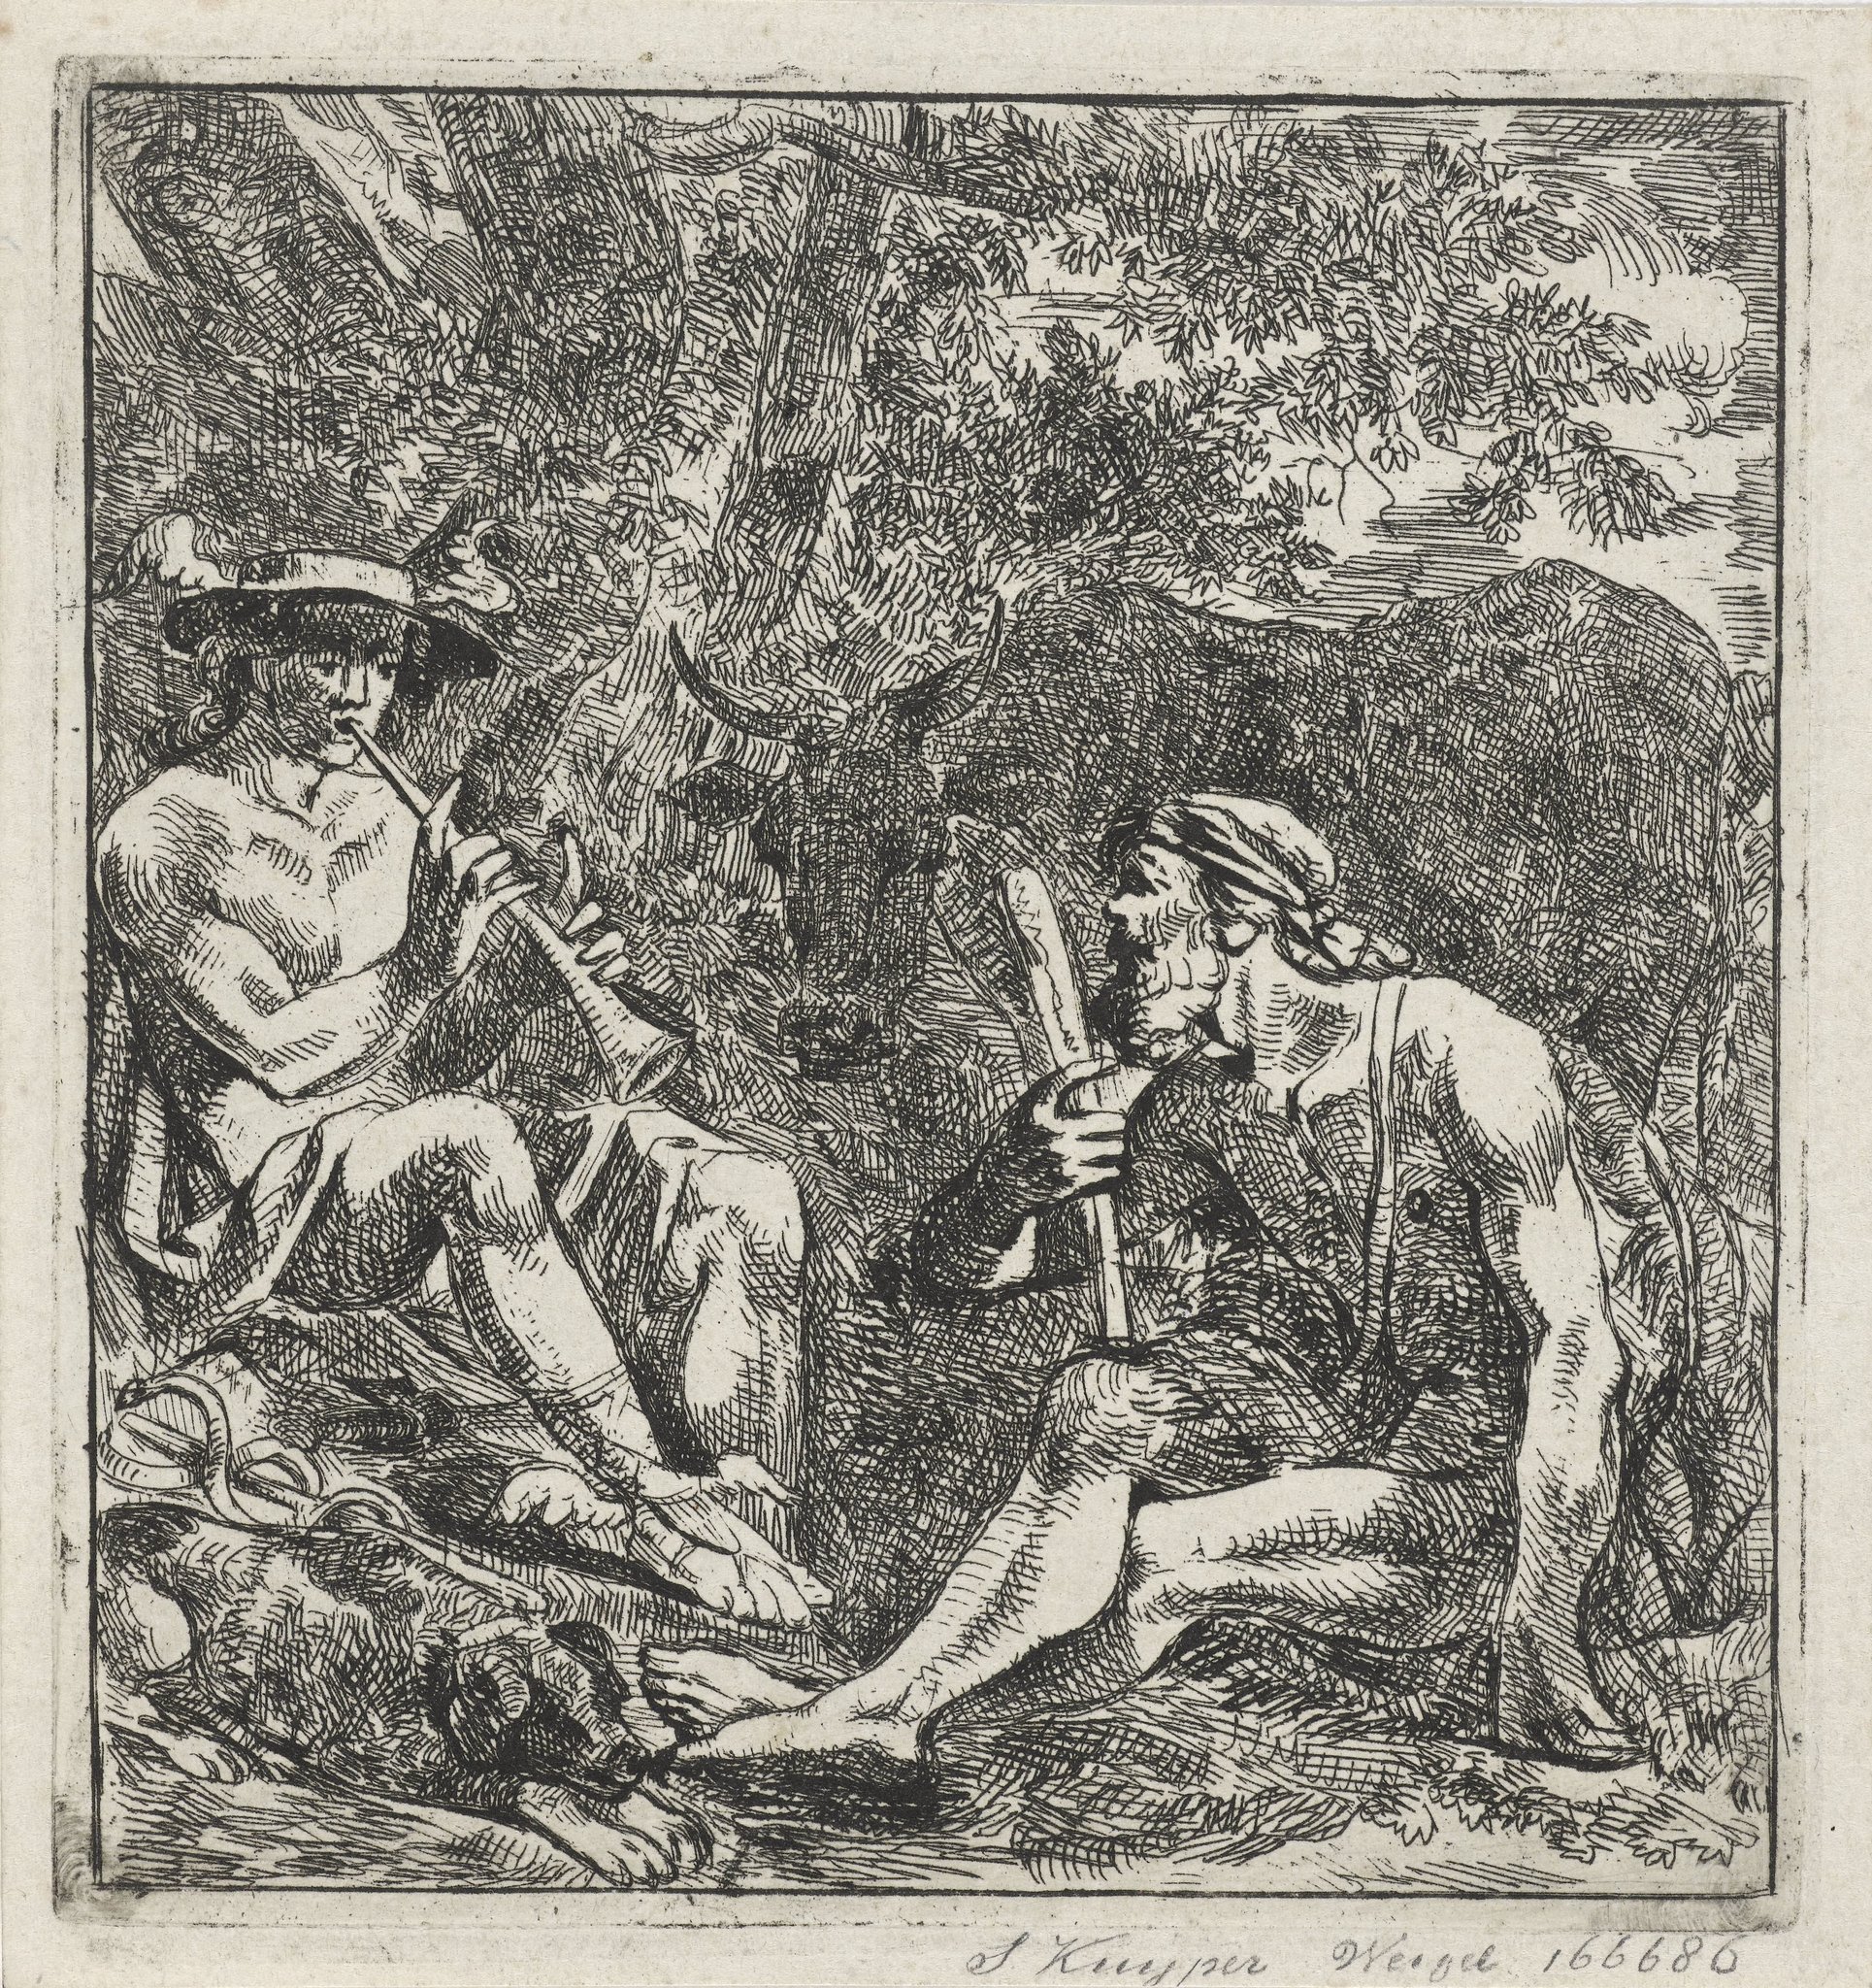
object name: print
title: Mercurius, Argus en Io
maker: jacques kuyper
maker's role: draughtsman, print maker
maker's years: 1761-1808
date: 1771-1808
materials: paper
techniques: etching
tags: mercury lulls argus into sleep by making music, dog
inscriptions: inscription: ‘J Kuijper Weigel 166686’, collector's mark: Lugt 2228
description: Onder een boom bespeelt Mercurius zijn herdersfluit om Argus, die tegenover hem zit, in slaap te sussen. Naast Mercurius liggen zijn staf en een hond. Schuin achter Argus staat Io in de gedaante van een koe.